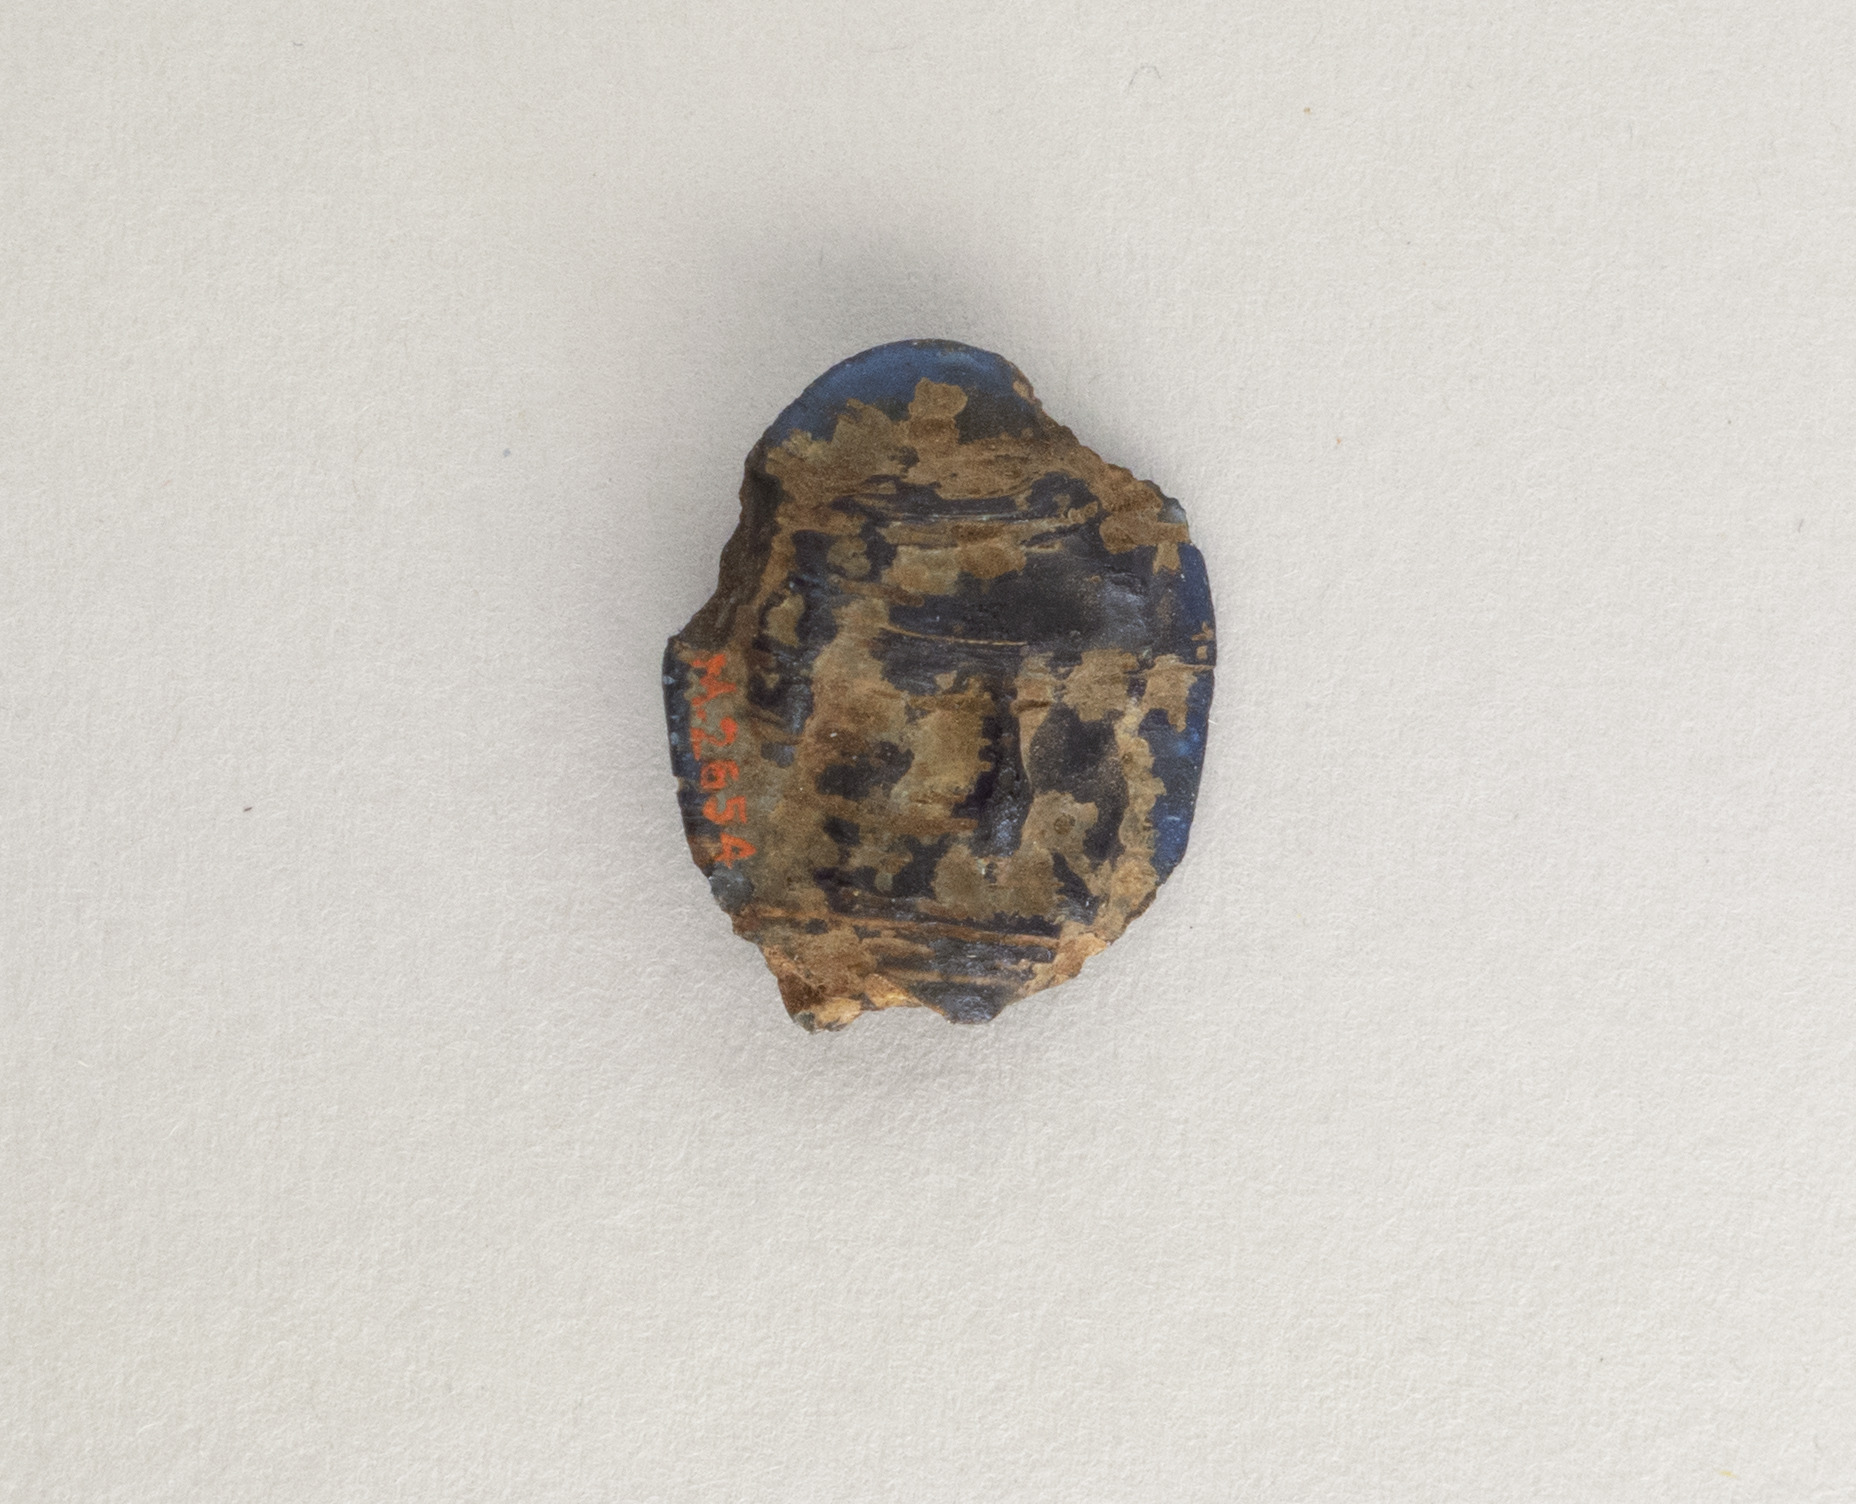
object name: pendant with male mask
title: Glass double-headed pendant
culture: punic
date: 334-201 BCE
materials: glass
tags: heads